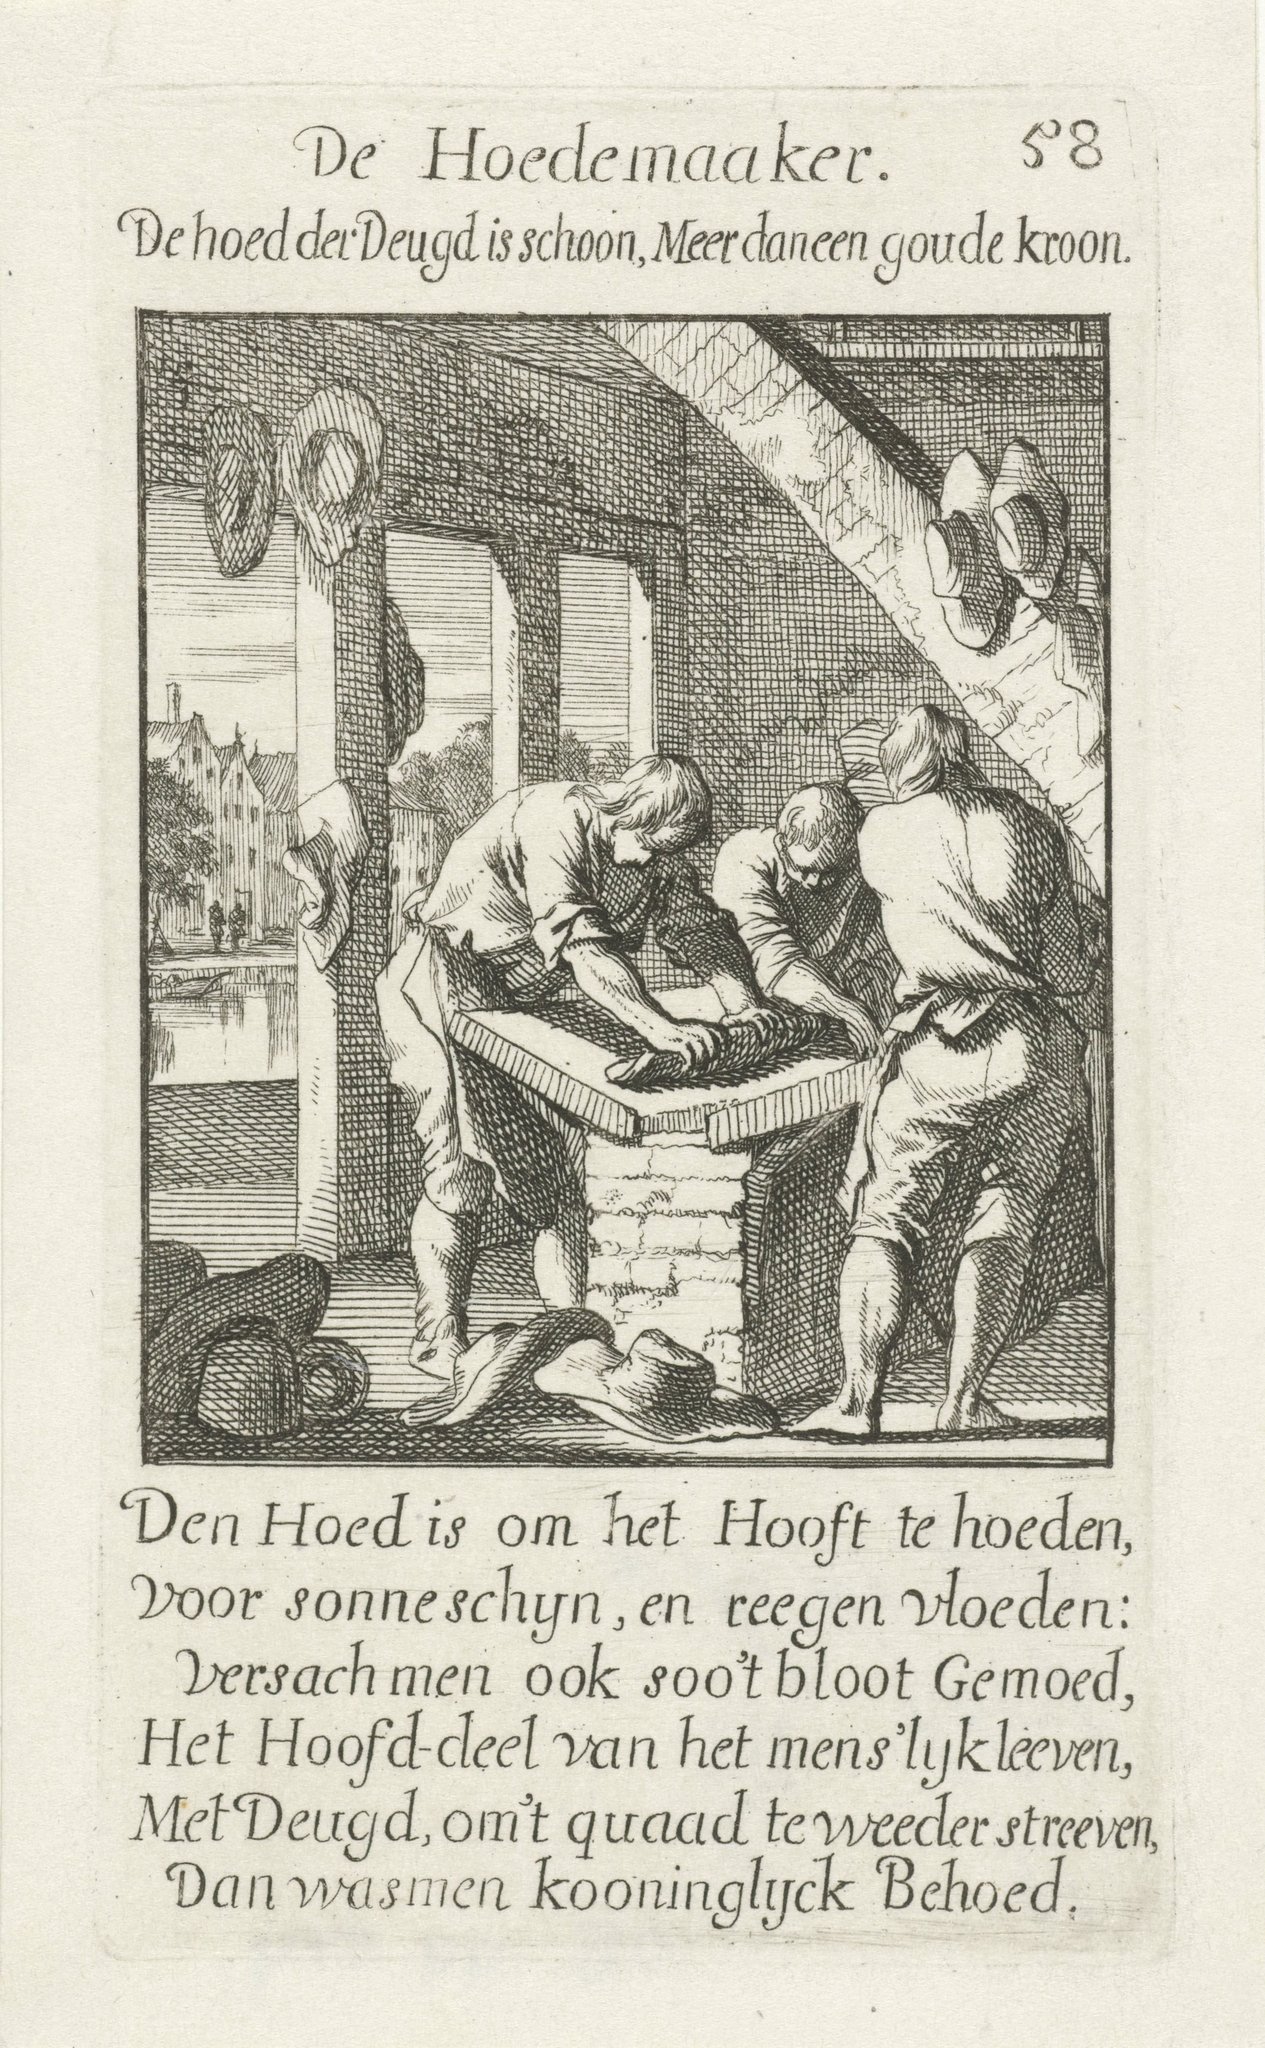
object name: print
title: Het Menselyk Bedryf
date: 1694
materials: paper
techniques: etching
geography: amsterdam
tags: handicrafts, craftsman at work, hatter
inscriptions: collector's mark: Lugt 2228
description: Maakt deel uit van de 100-delige serie beroepsprenten van Jan en Caspar Luyken, getiteld: Het menselyk bedryf. S.l.s.n., 1694 (eerste druk).